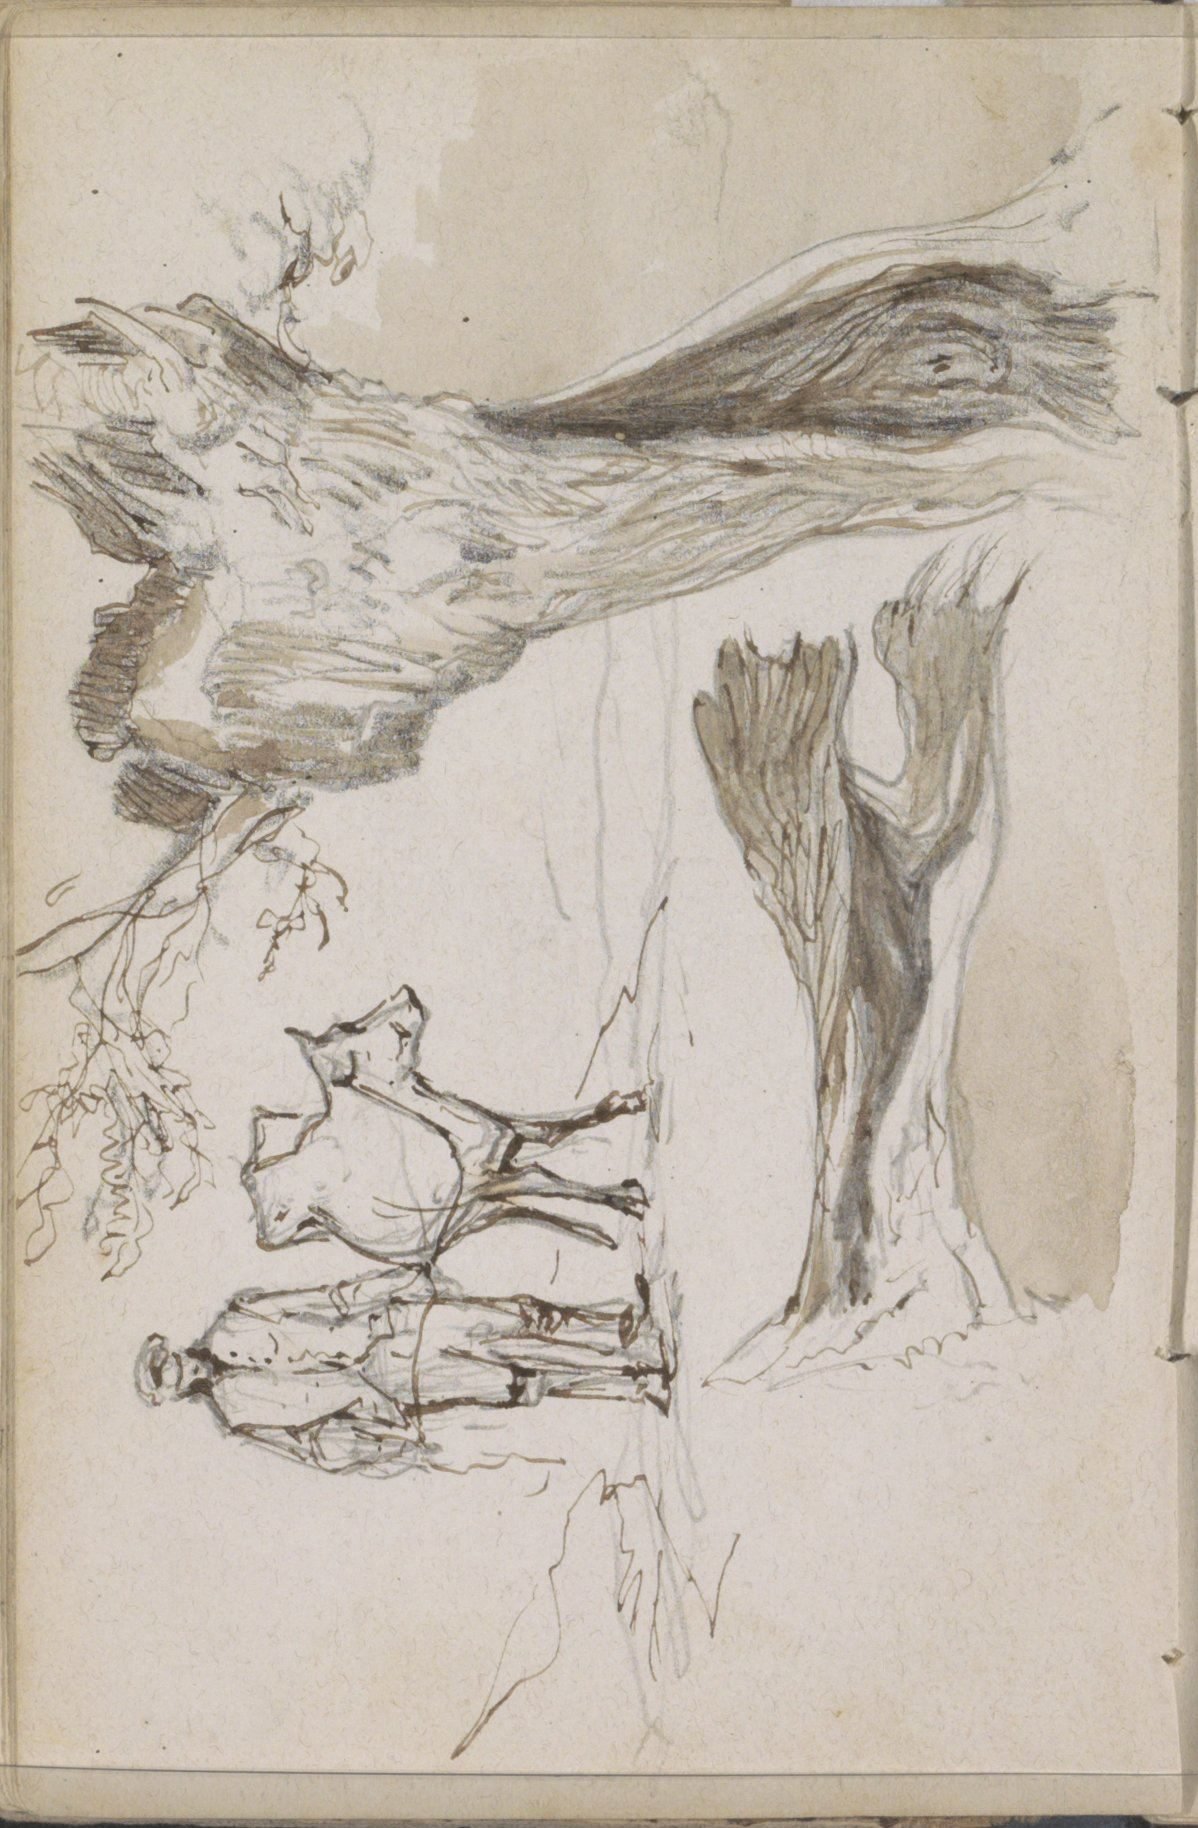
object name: sketchbook leaf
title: Boomstammen en een man met een koe aan een touw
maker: johannes tavenraat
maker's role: draughtsman, painter, print maker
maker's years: 1809-1881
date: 1862-1864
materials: ink, paper, pencil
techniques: brush, pen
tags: trees, cow, farmers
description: Blad 11 verso uit een schetsboek met 65 bladen.